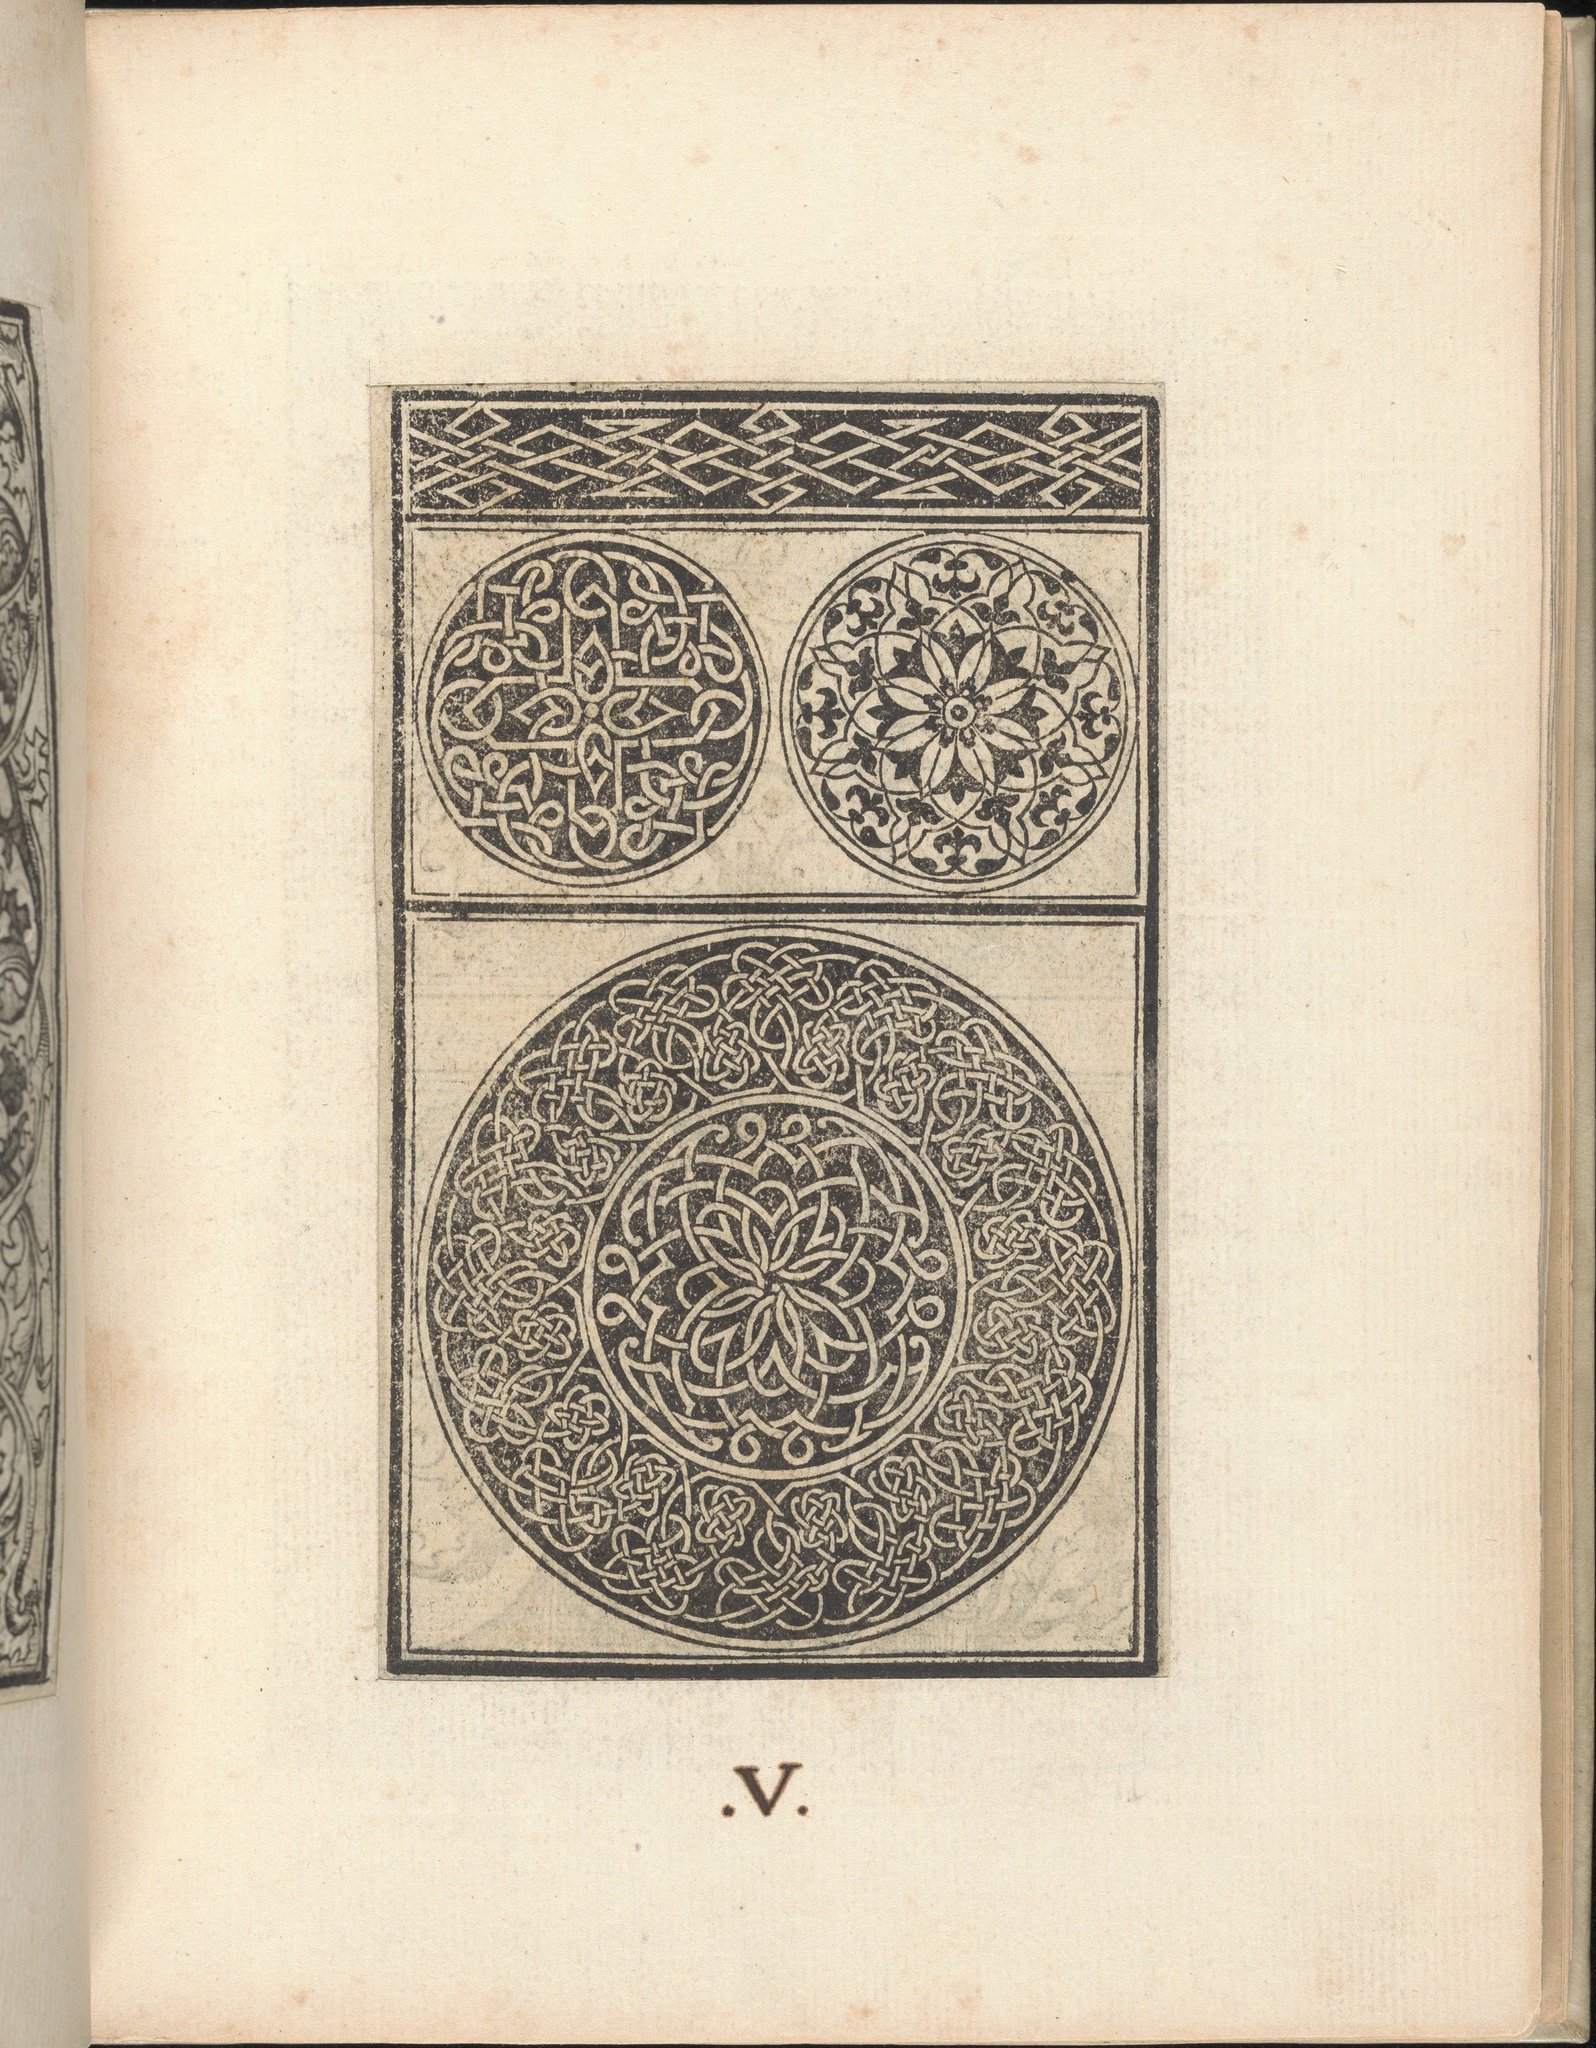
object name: book print ornament architecture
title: Esemplario di lavori, page 5 (recto)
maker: nicolò zoppino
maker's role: publisher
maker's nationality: italian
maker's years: 1478-1544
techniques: bookbinding, inlay, woodcut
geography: italy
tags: ornament